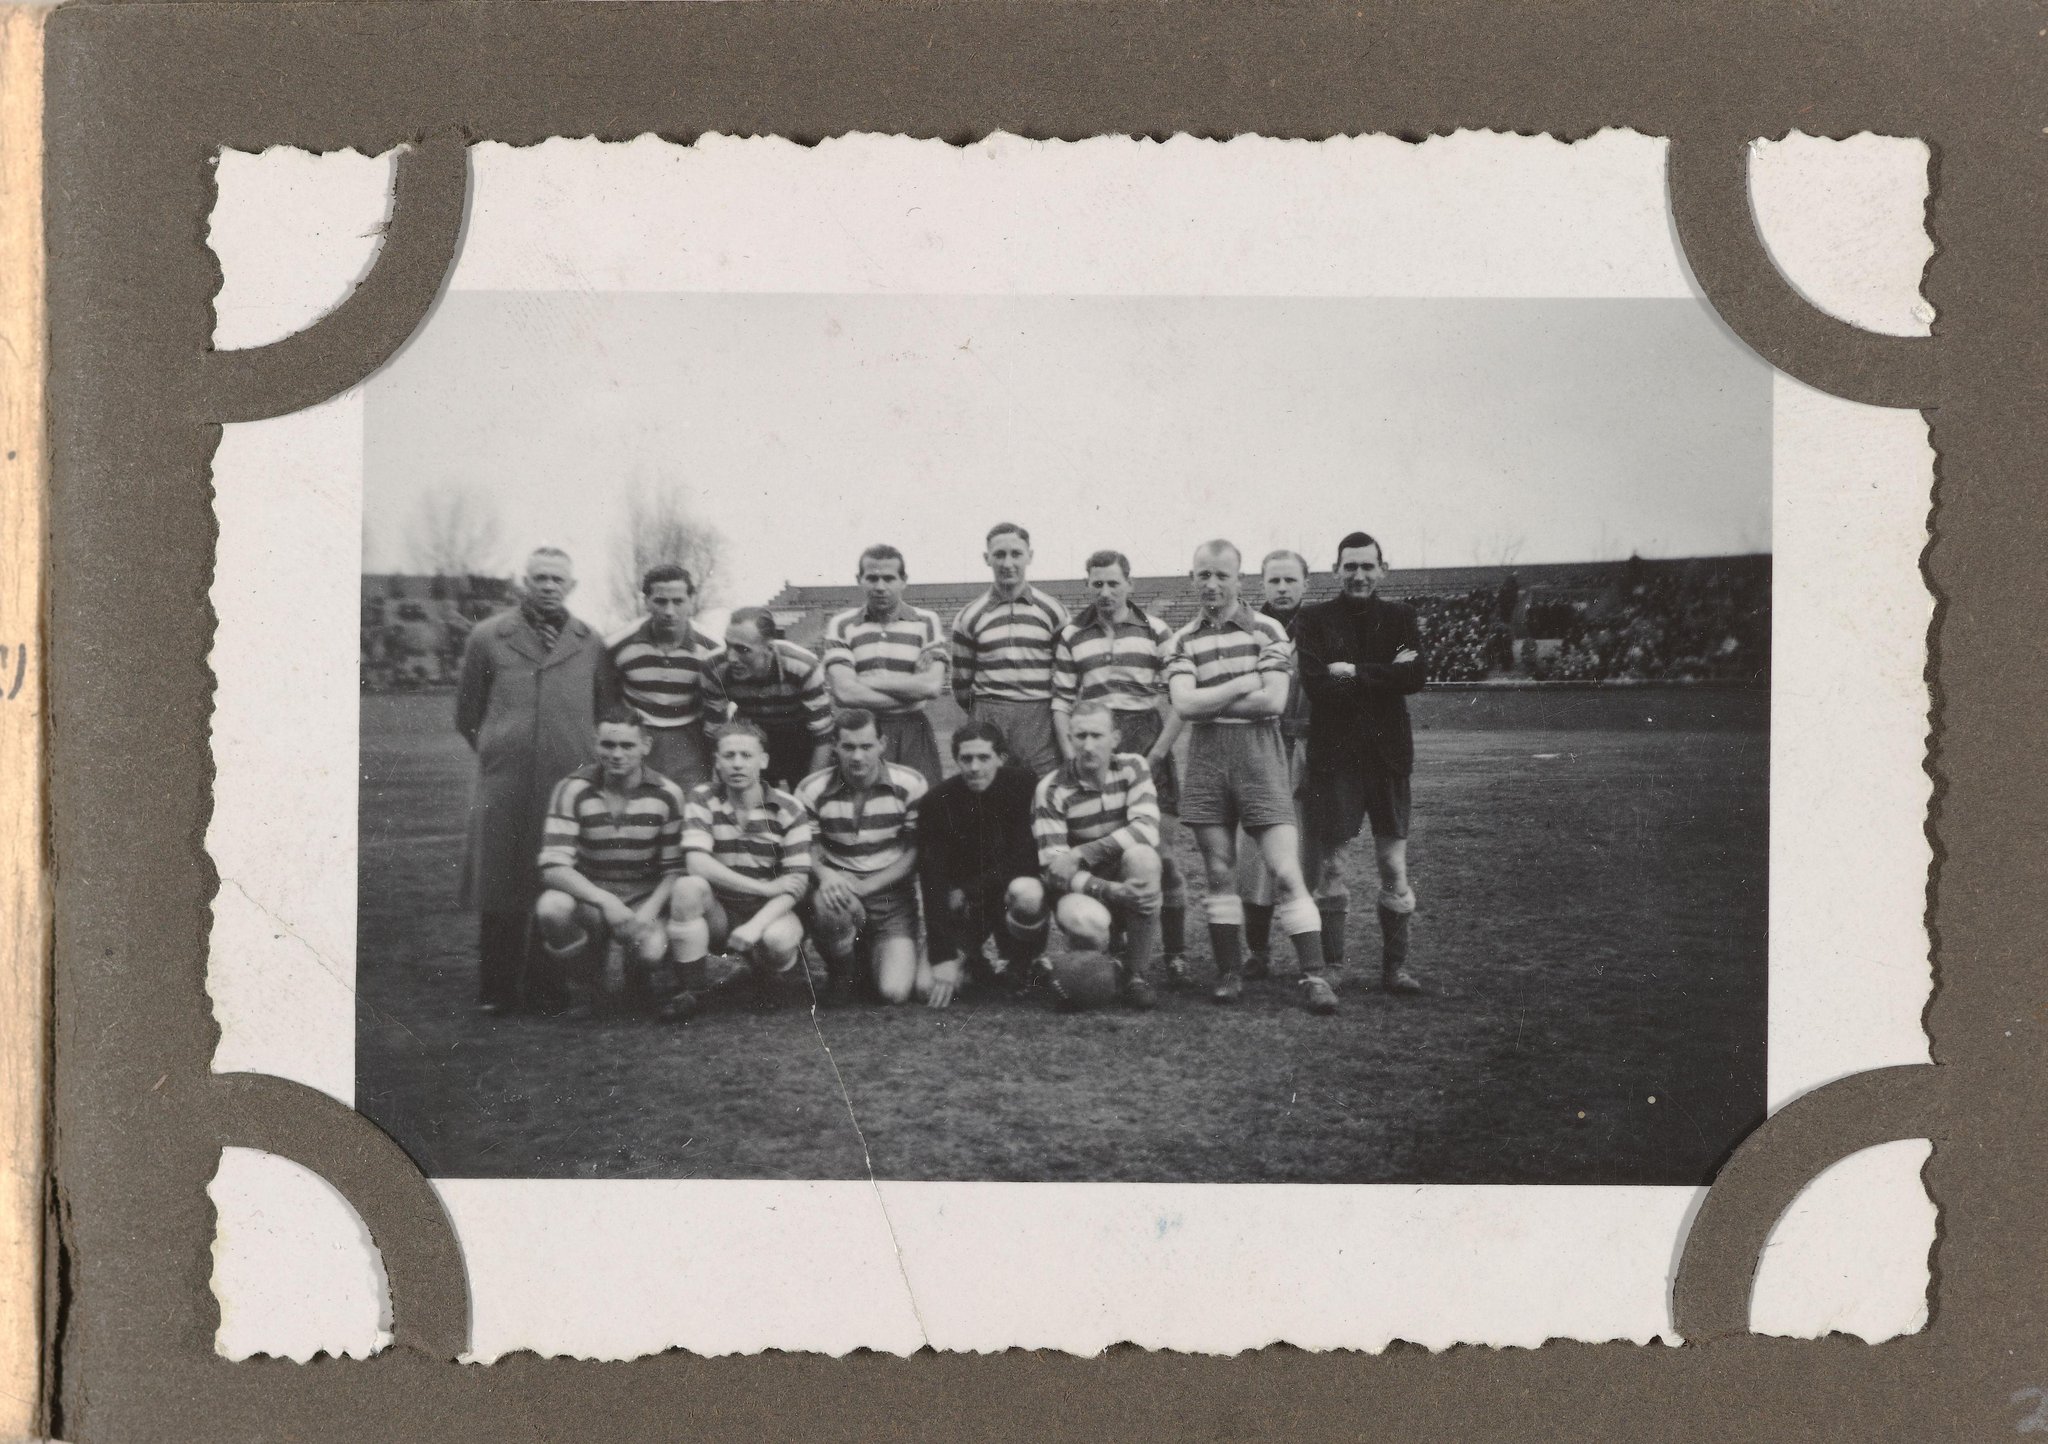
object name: photograph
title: Groepsfoto voetbalelftal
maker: Anonymous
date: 1933-1944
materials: photographic support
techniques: gelatin silver print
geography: rotterdam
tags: wim van den bosch, rotterdam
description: Groepsfoto van een voetbalelftal. Onderdeel van het familiealbum 1933-1944.